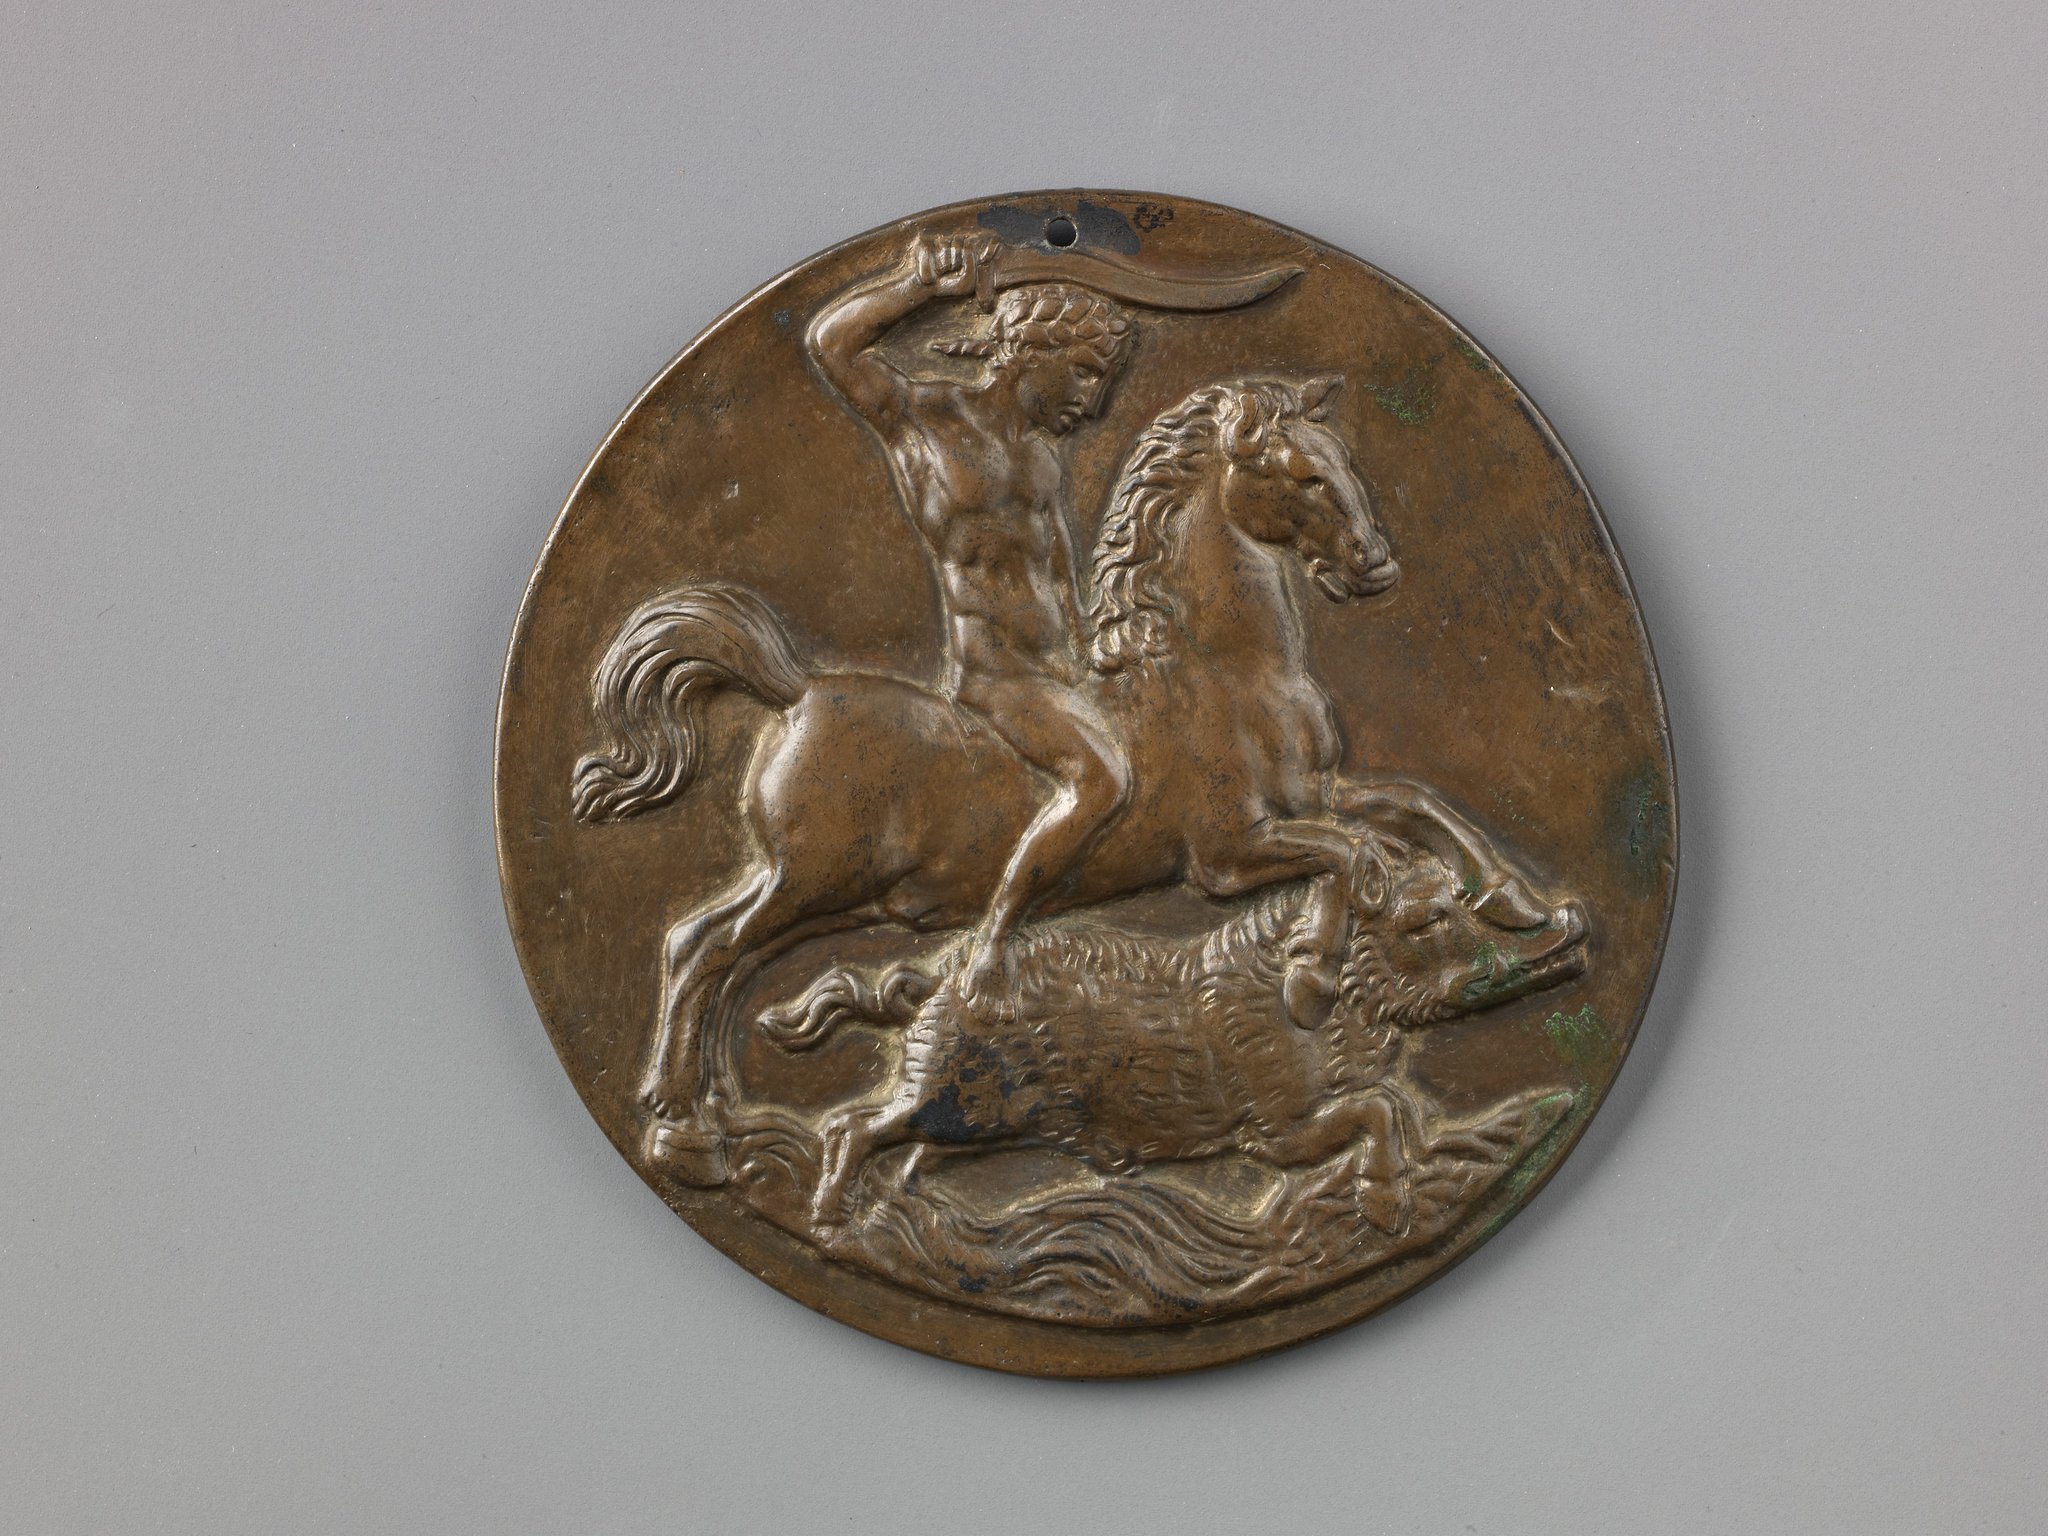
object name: plaquette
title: Meleager Hunting the Boar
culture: italian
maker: pseudo-melioli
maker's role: artist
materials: copper alloy, patina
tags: men,hunting,boars,horses